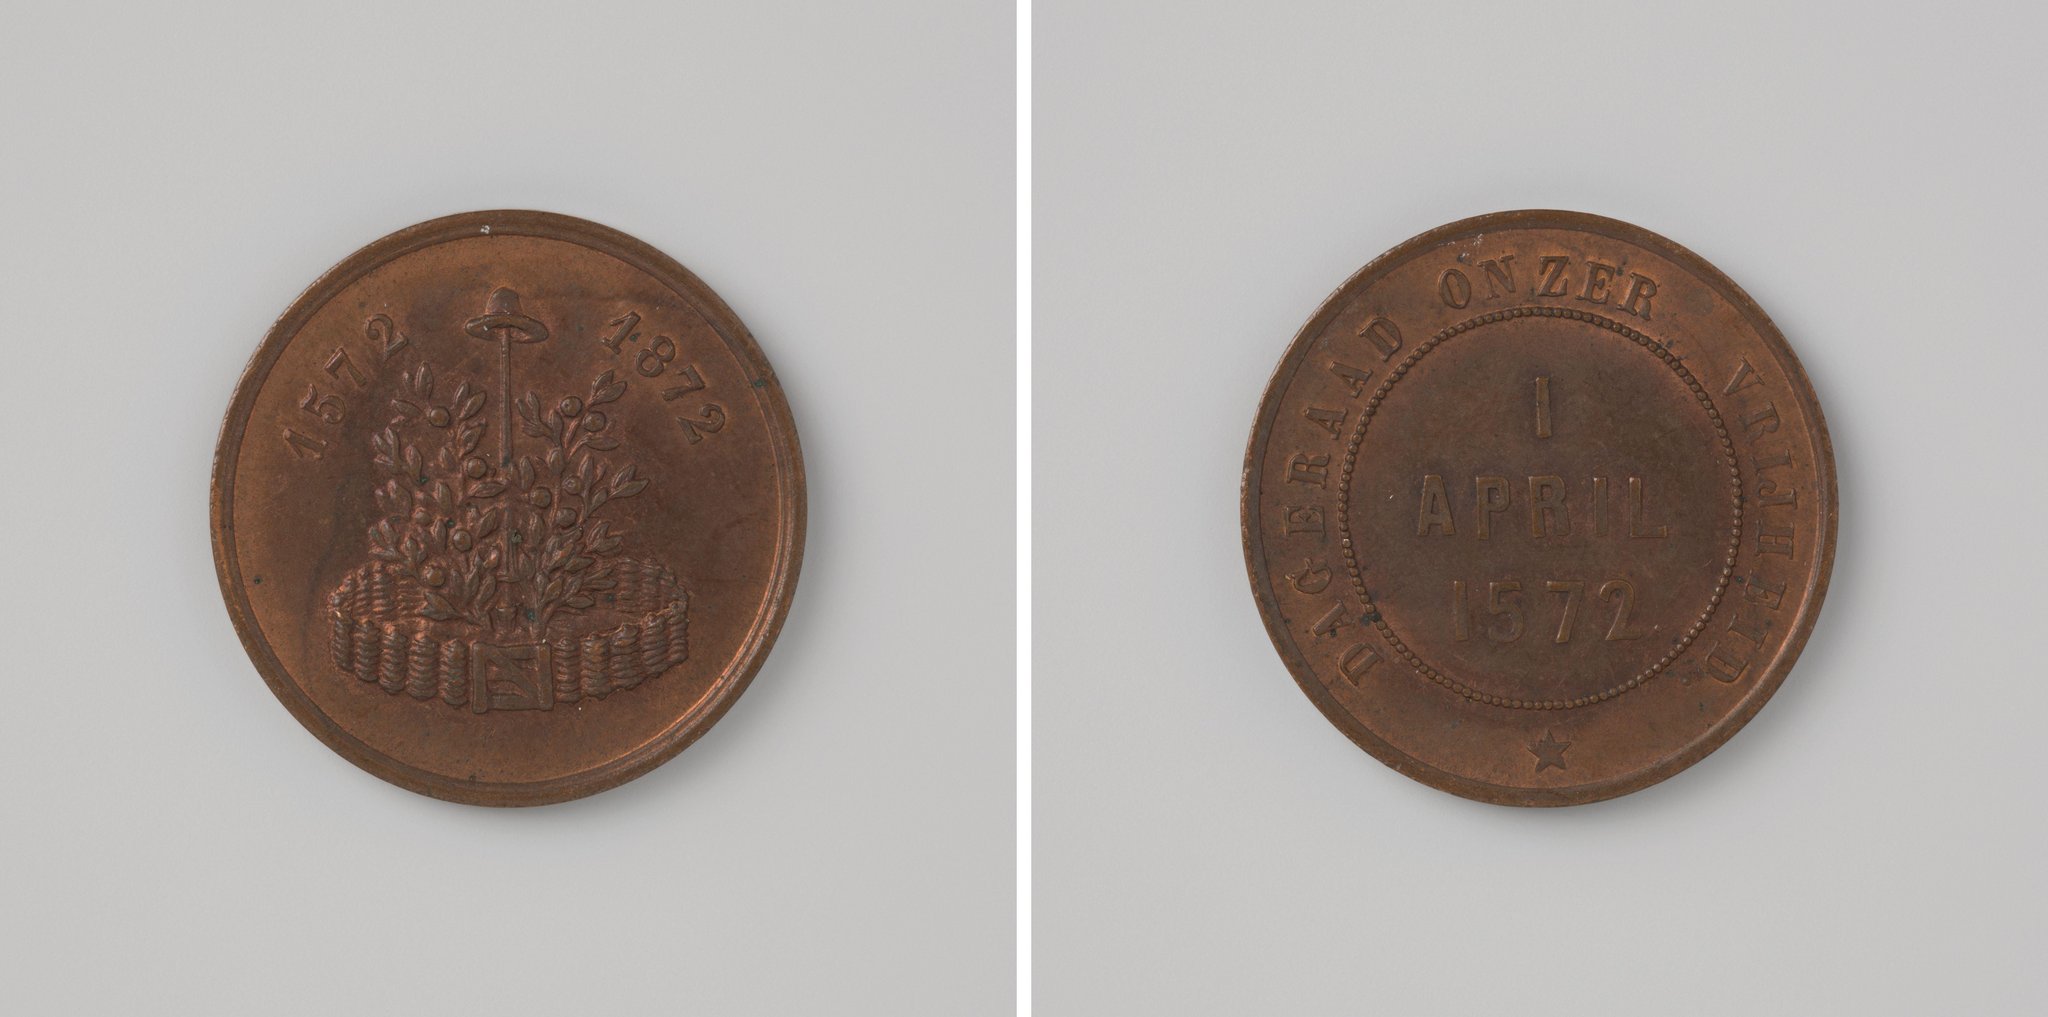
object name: history medal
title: Driehonderdjarige herdenking van de inname van Den Briel door de Watergeuzen (Aprilfeesten) 1872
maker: johan philip menger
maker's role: medailleur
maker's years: 1818-1895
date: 1872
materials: bronze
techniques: striking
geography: utrecht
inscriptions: circumscription: ‘DAGERAAD ONZER VRIJHEID. (ster)’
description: Bronzen penning, op de voorzijde een lans met vrijheidshoed en een oranjeboom in een omheinde tuin met bovenaan omschrift, op de keerzijde drie regels tekst met omschrift.